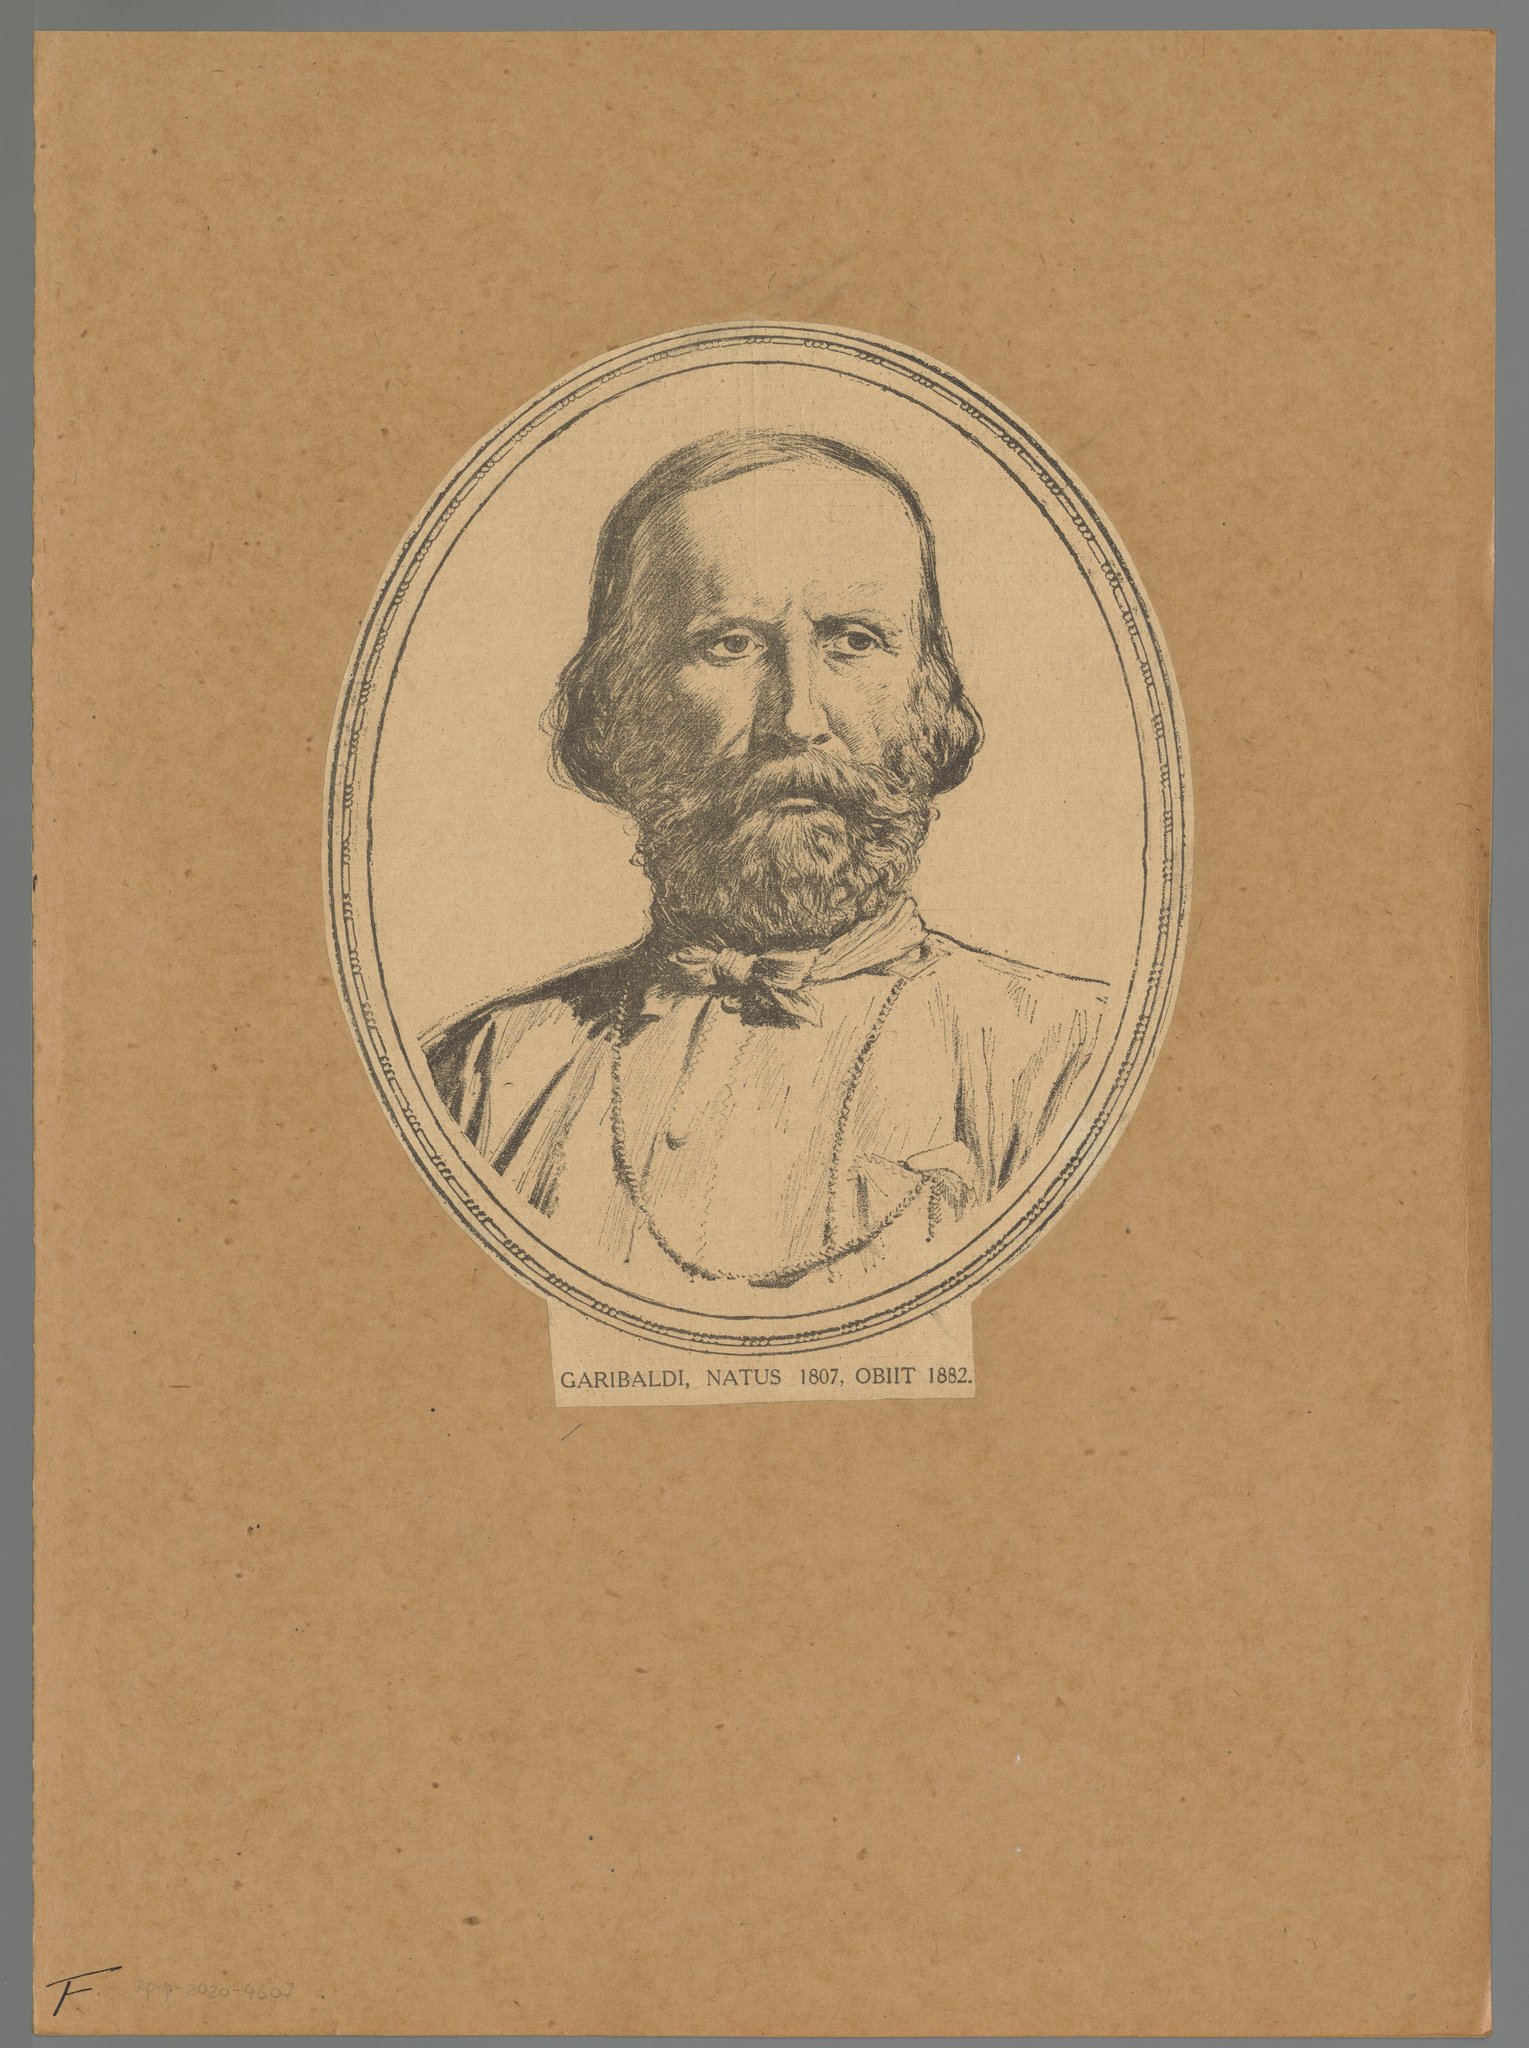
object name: photomechanical print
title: Portret van Giuseppe Garibaldi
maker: Anonymous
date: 1882-1920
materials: paper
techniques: letterpress printing, printing block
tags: commander-in-chief, general, marshal, historical persons